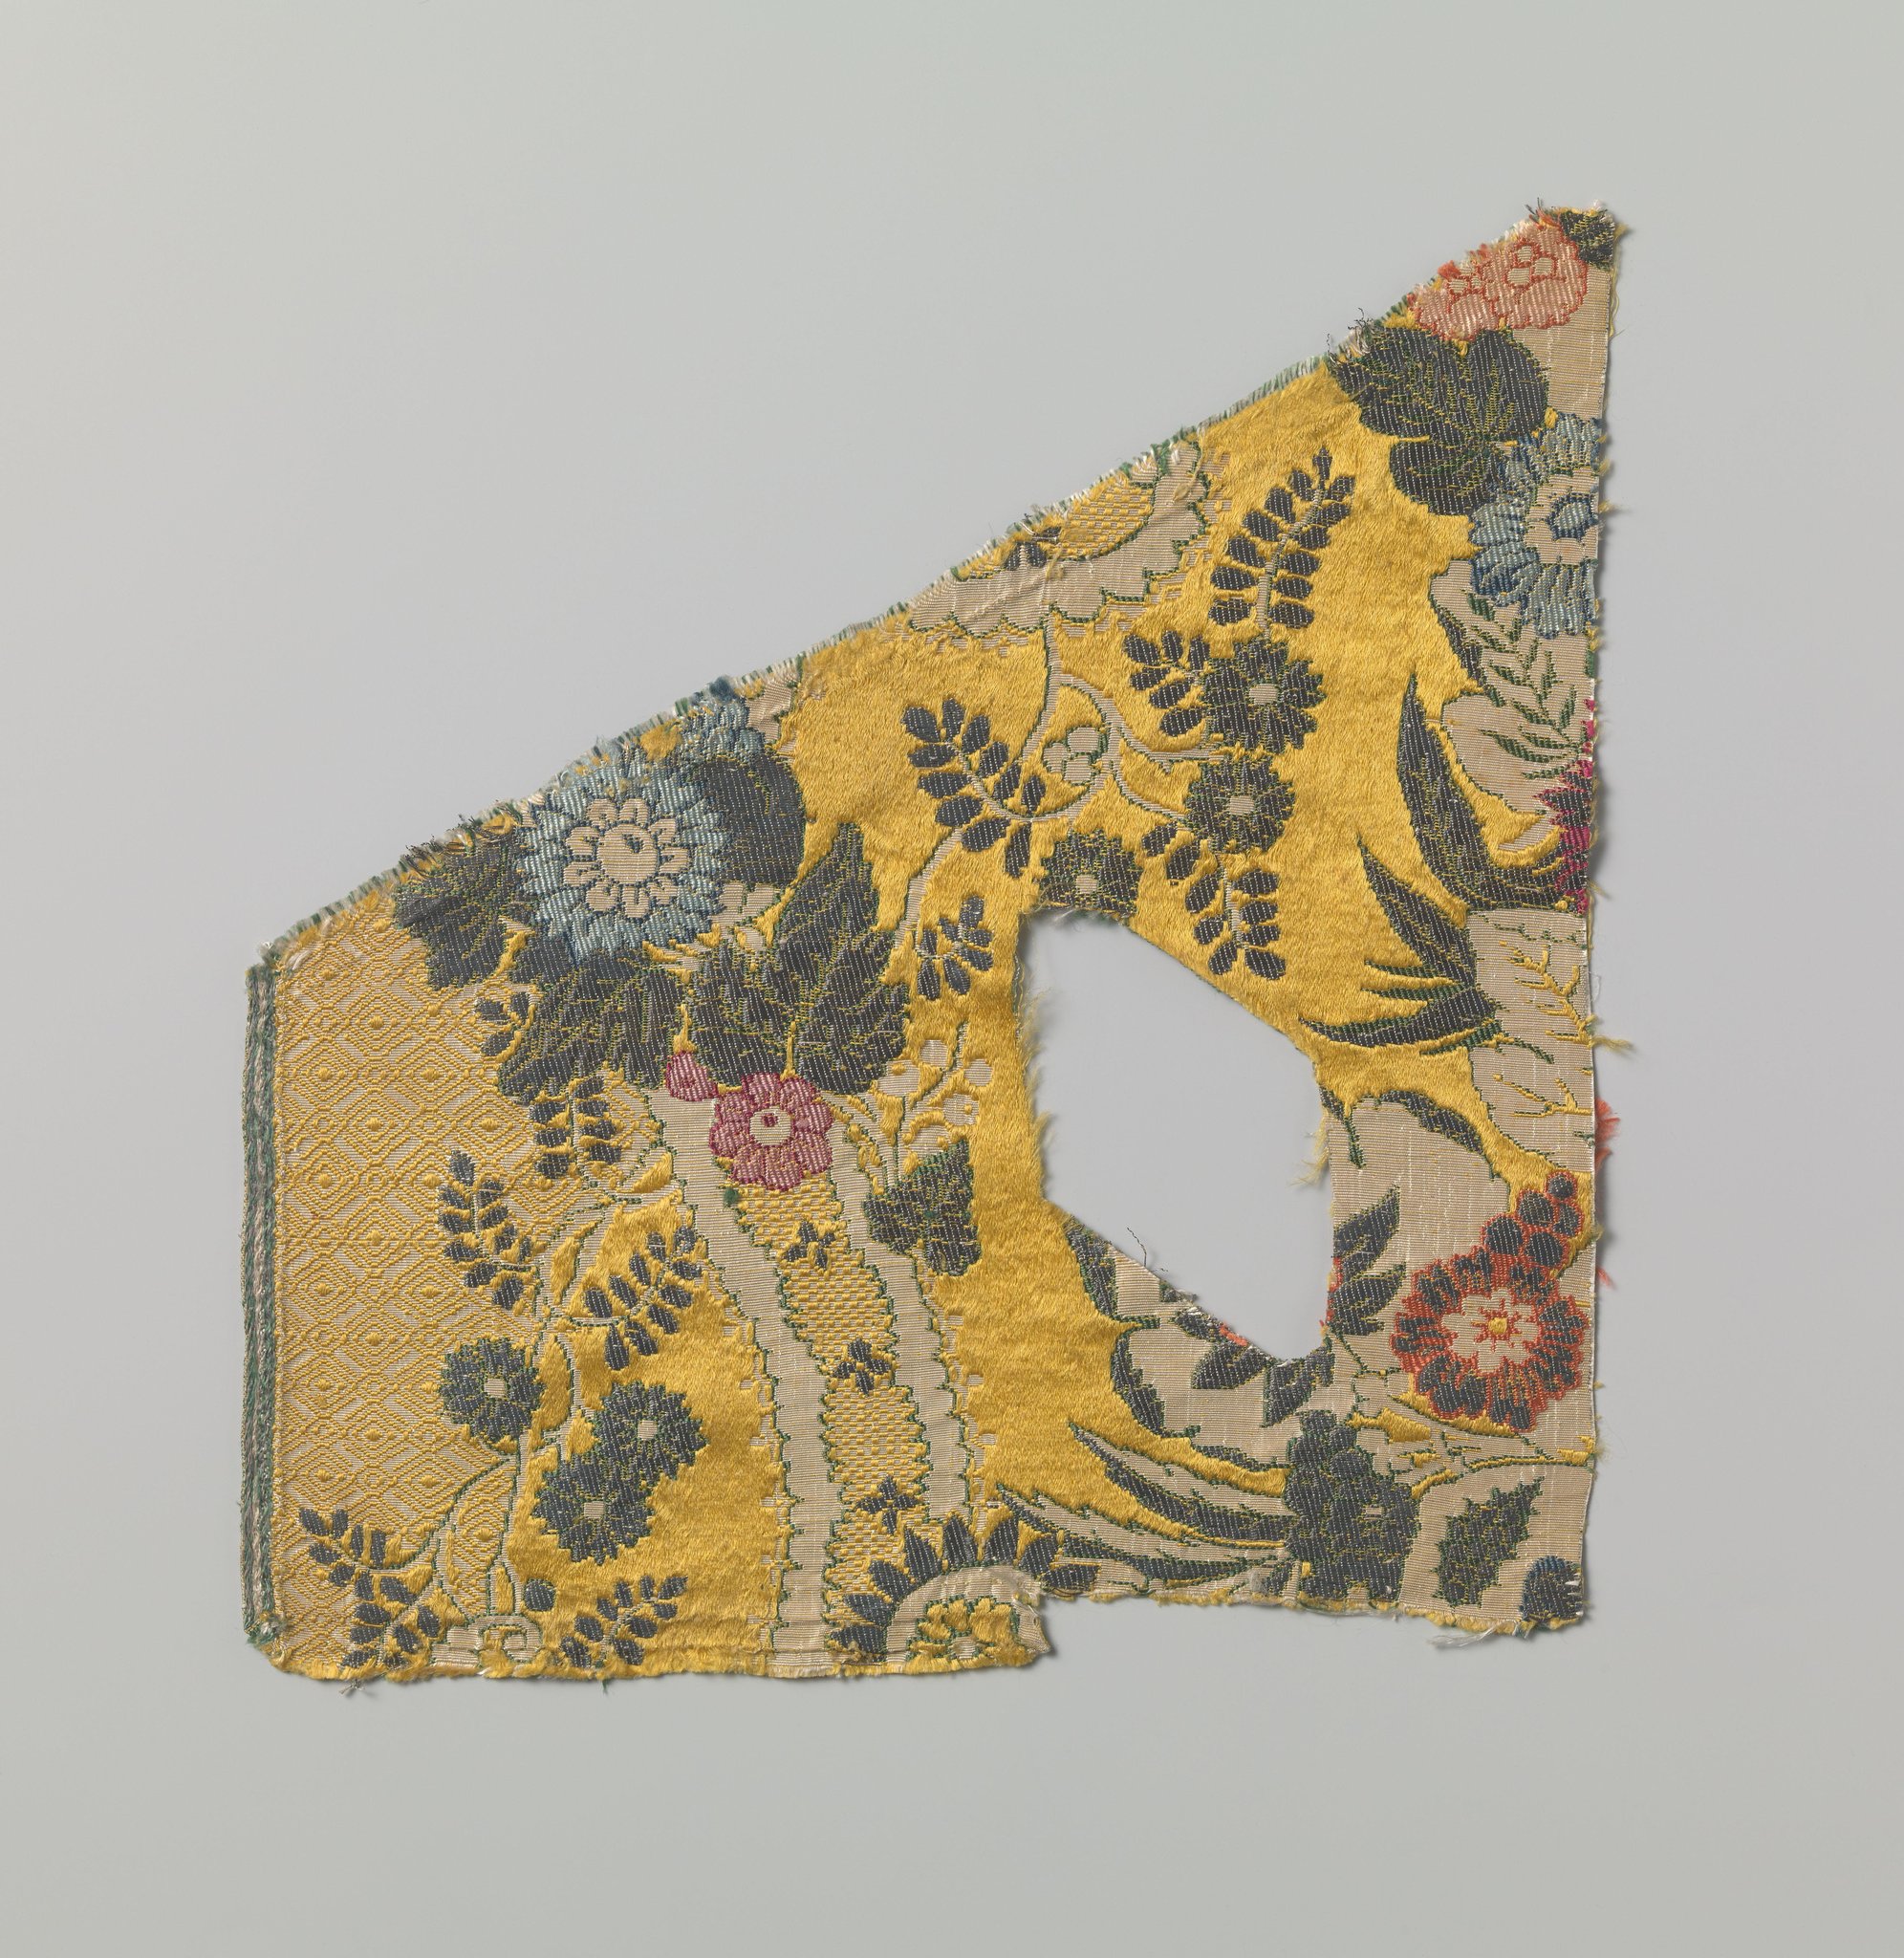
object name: fragment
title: Fragment veelkleurige gebrocheerde zijde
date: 1750-1800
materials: silk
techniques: brocade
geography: netherlands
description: Fragment veelkleurig zijdeweefsel. Een gele grond heeft een meerkleurige patroon van slingers met bloem- en bladdecoratie.